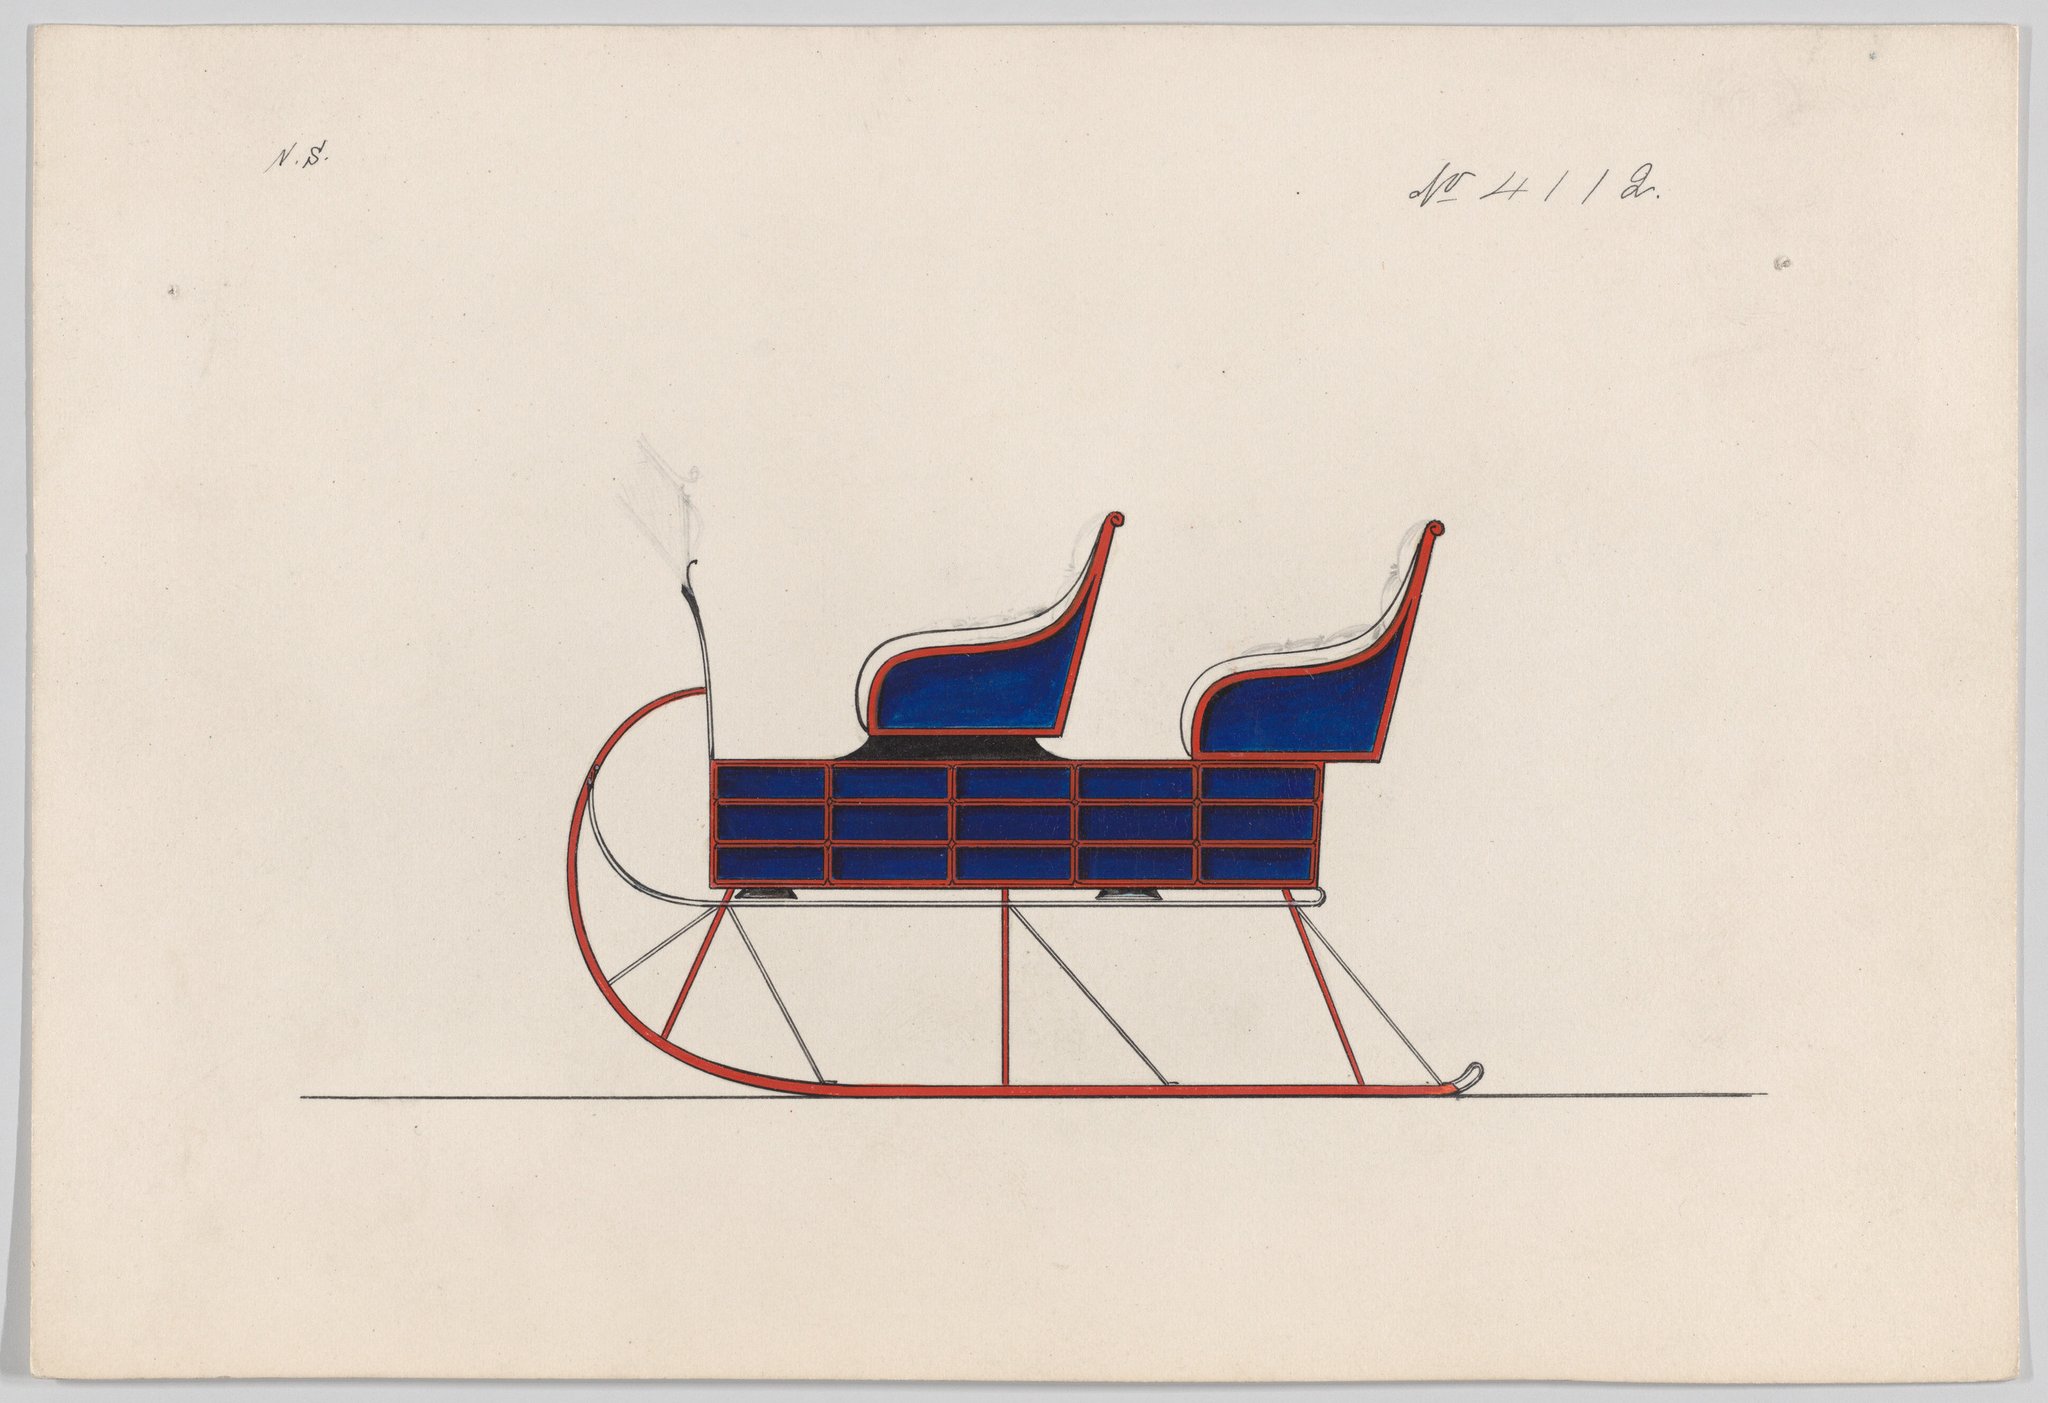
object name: drawing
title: Design for 4 Seat Sleigh, no. 4112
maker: brewster & co.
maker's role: manufacturer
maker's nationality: american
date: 1890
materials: gouache, gum arabic, ink, watercolor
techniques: pen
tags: sleighs